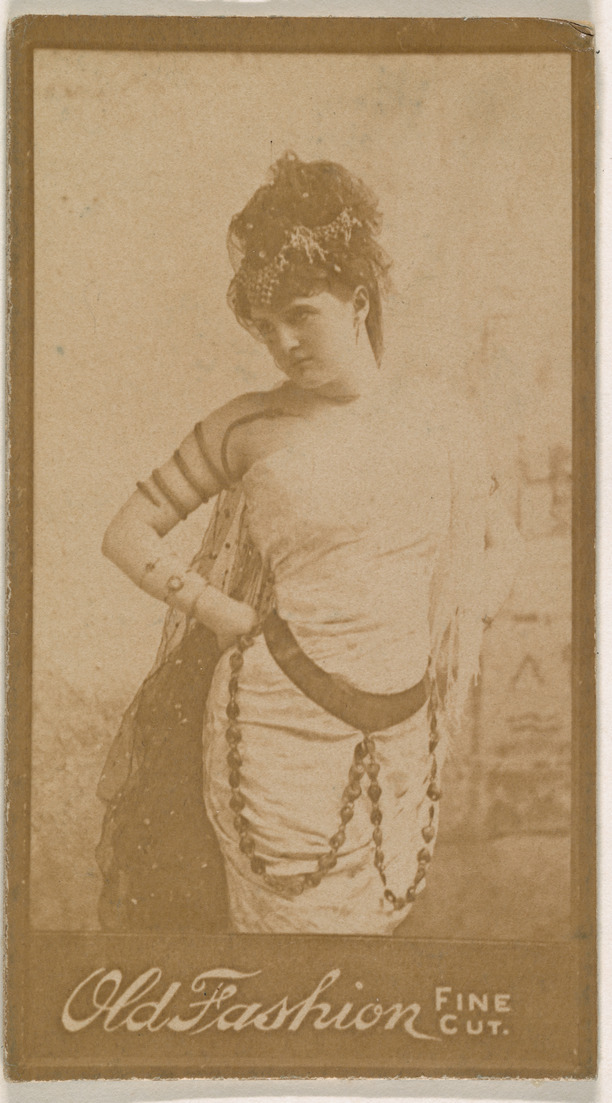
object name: photograph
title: Actress wearing costume with spiral armband, from the Actresses series (N664) promoting Old Fashion Fine Cut Tobacco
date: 1888-1890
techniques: albumen silver print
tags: portraits,women,actresses